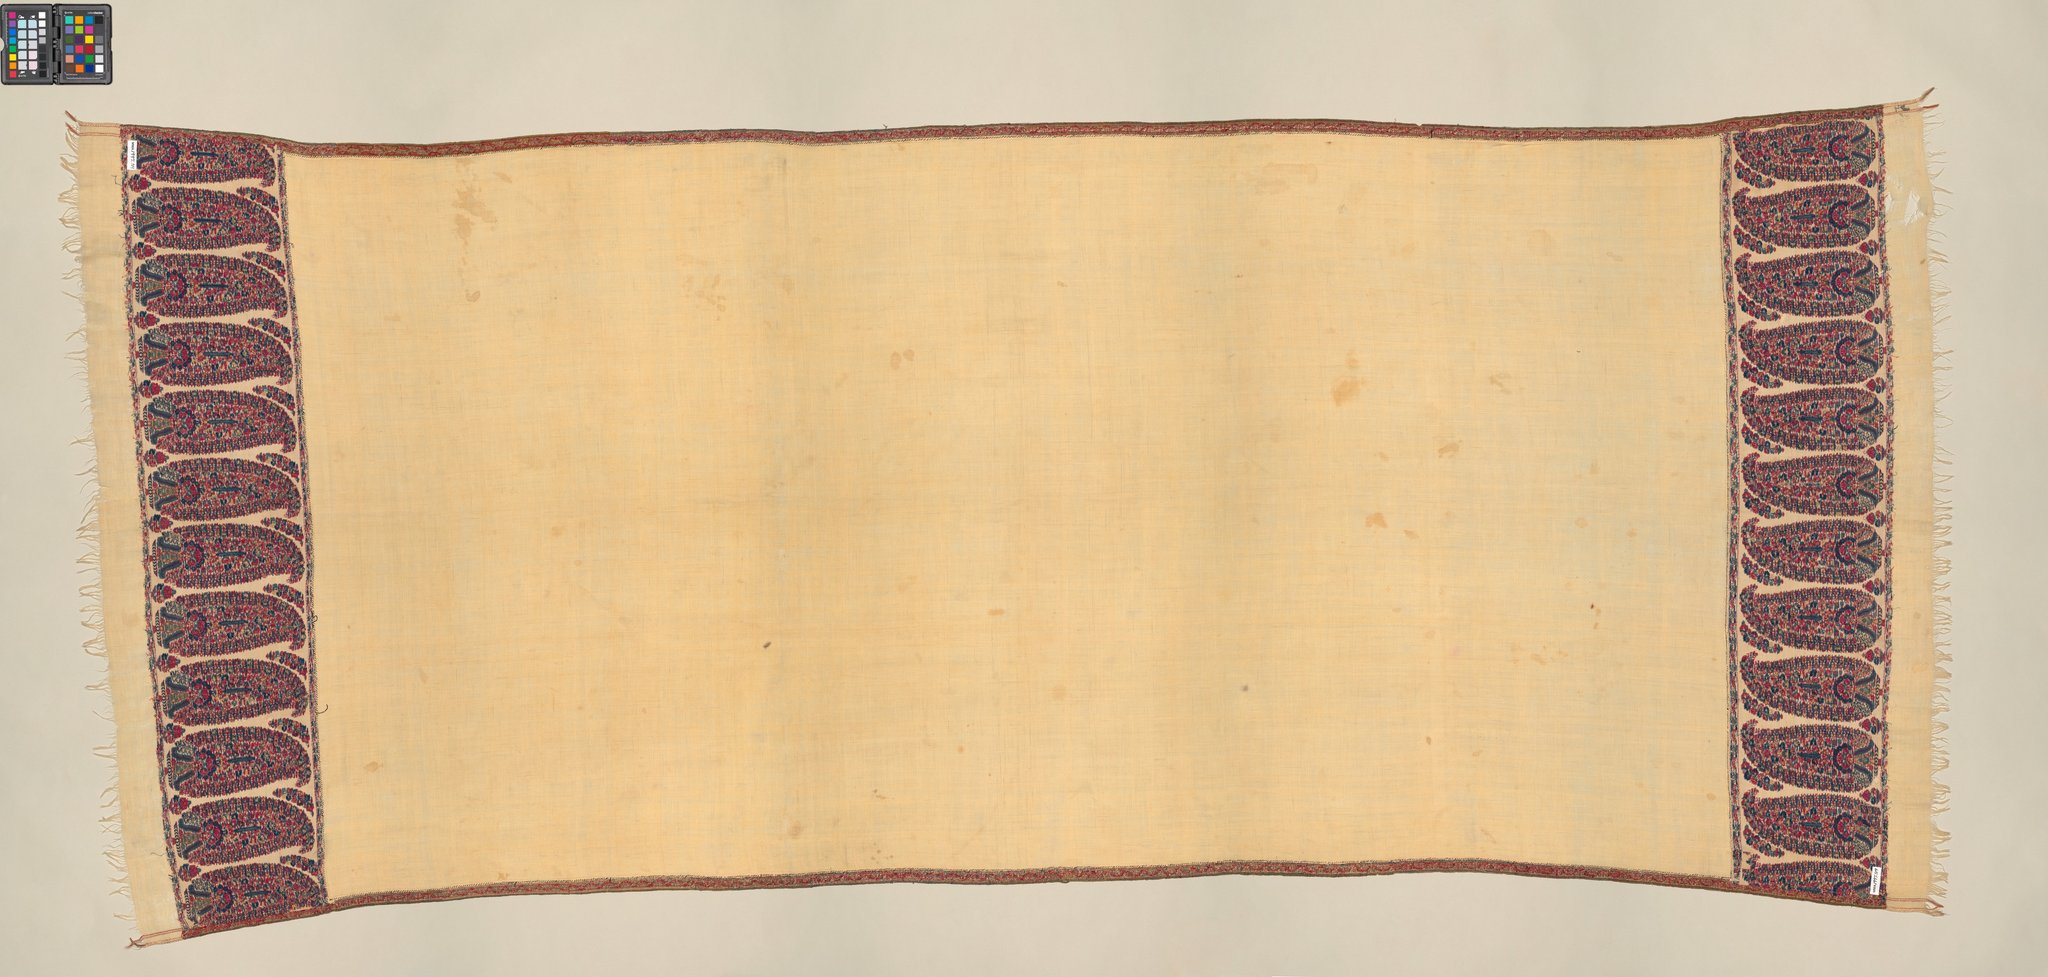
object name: shawl of joined fragment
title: Shawl of Joined Fragments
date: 1767-1800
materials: wool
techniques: interlocking, weave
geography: india